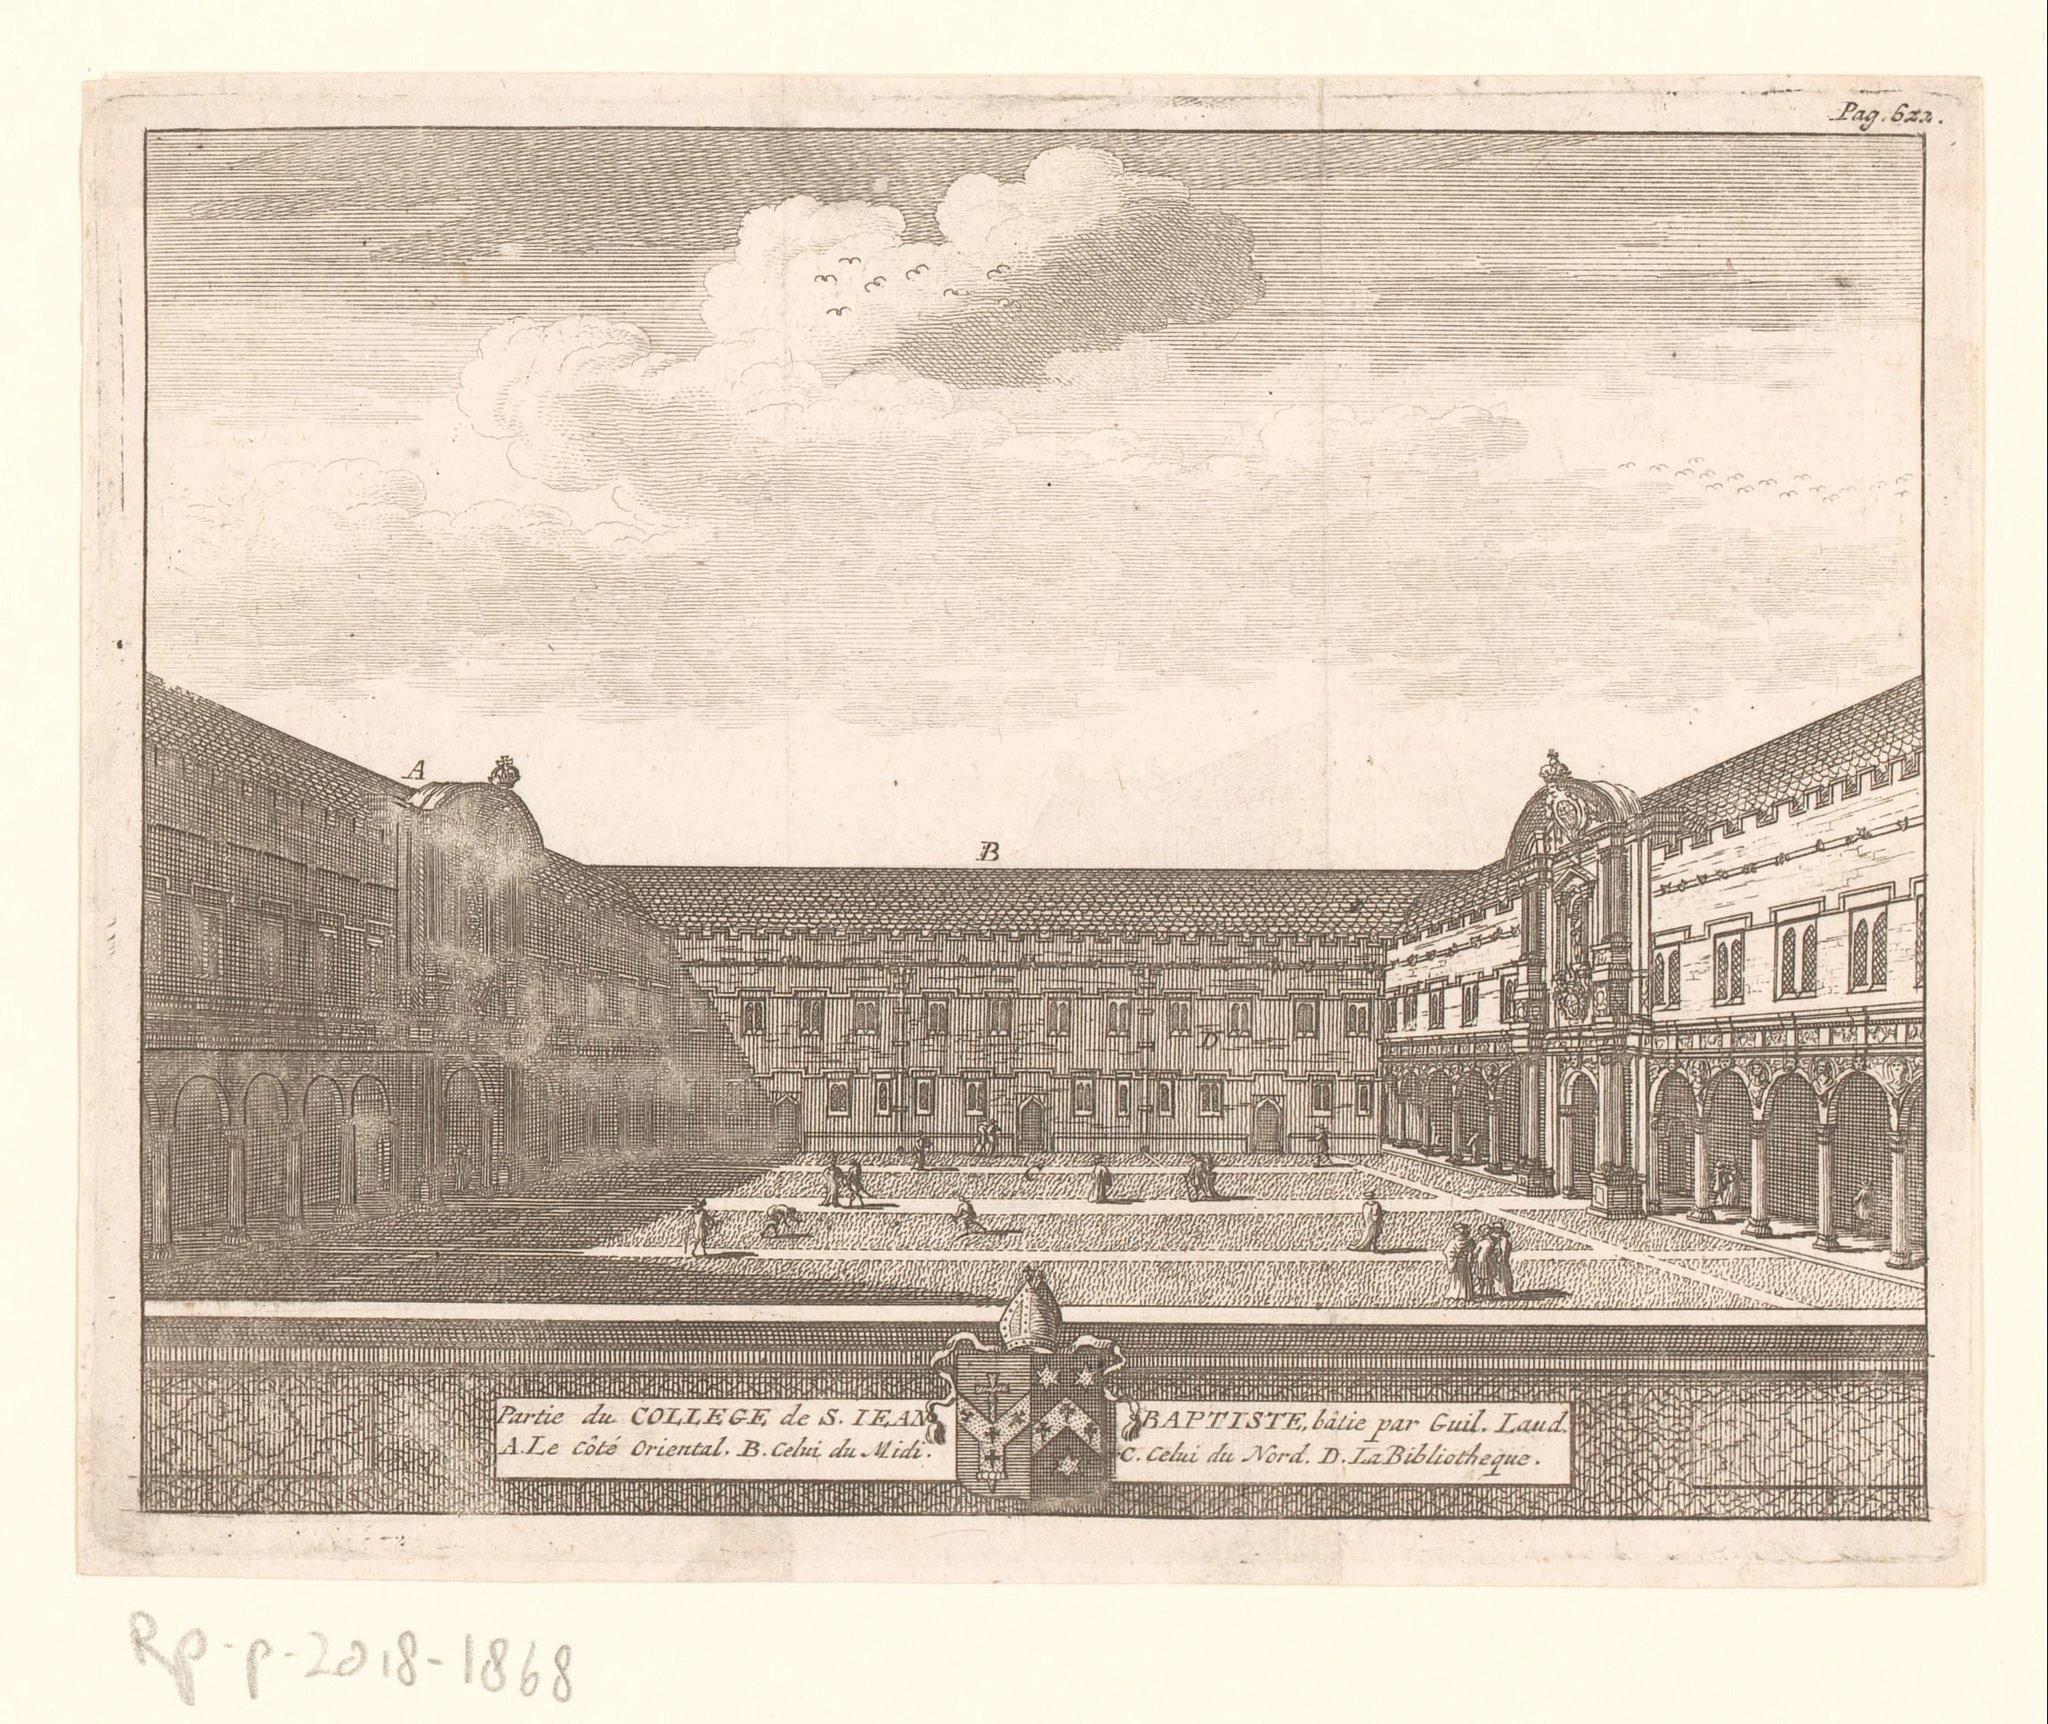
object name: print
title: Gezicht op St. Johns College, Oxford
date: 1707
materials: paper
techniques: etching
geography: leiden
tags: university building, college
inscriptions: collector's mark: Lugt 2228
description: Prent gebruikt in: Beeverell, James. Les Delices de la Grande Bretagne et de l'Irlande (...). Leiden: Pieter van der Aa, 1707.